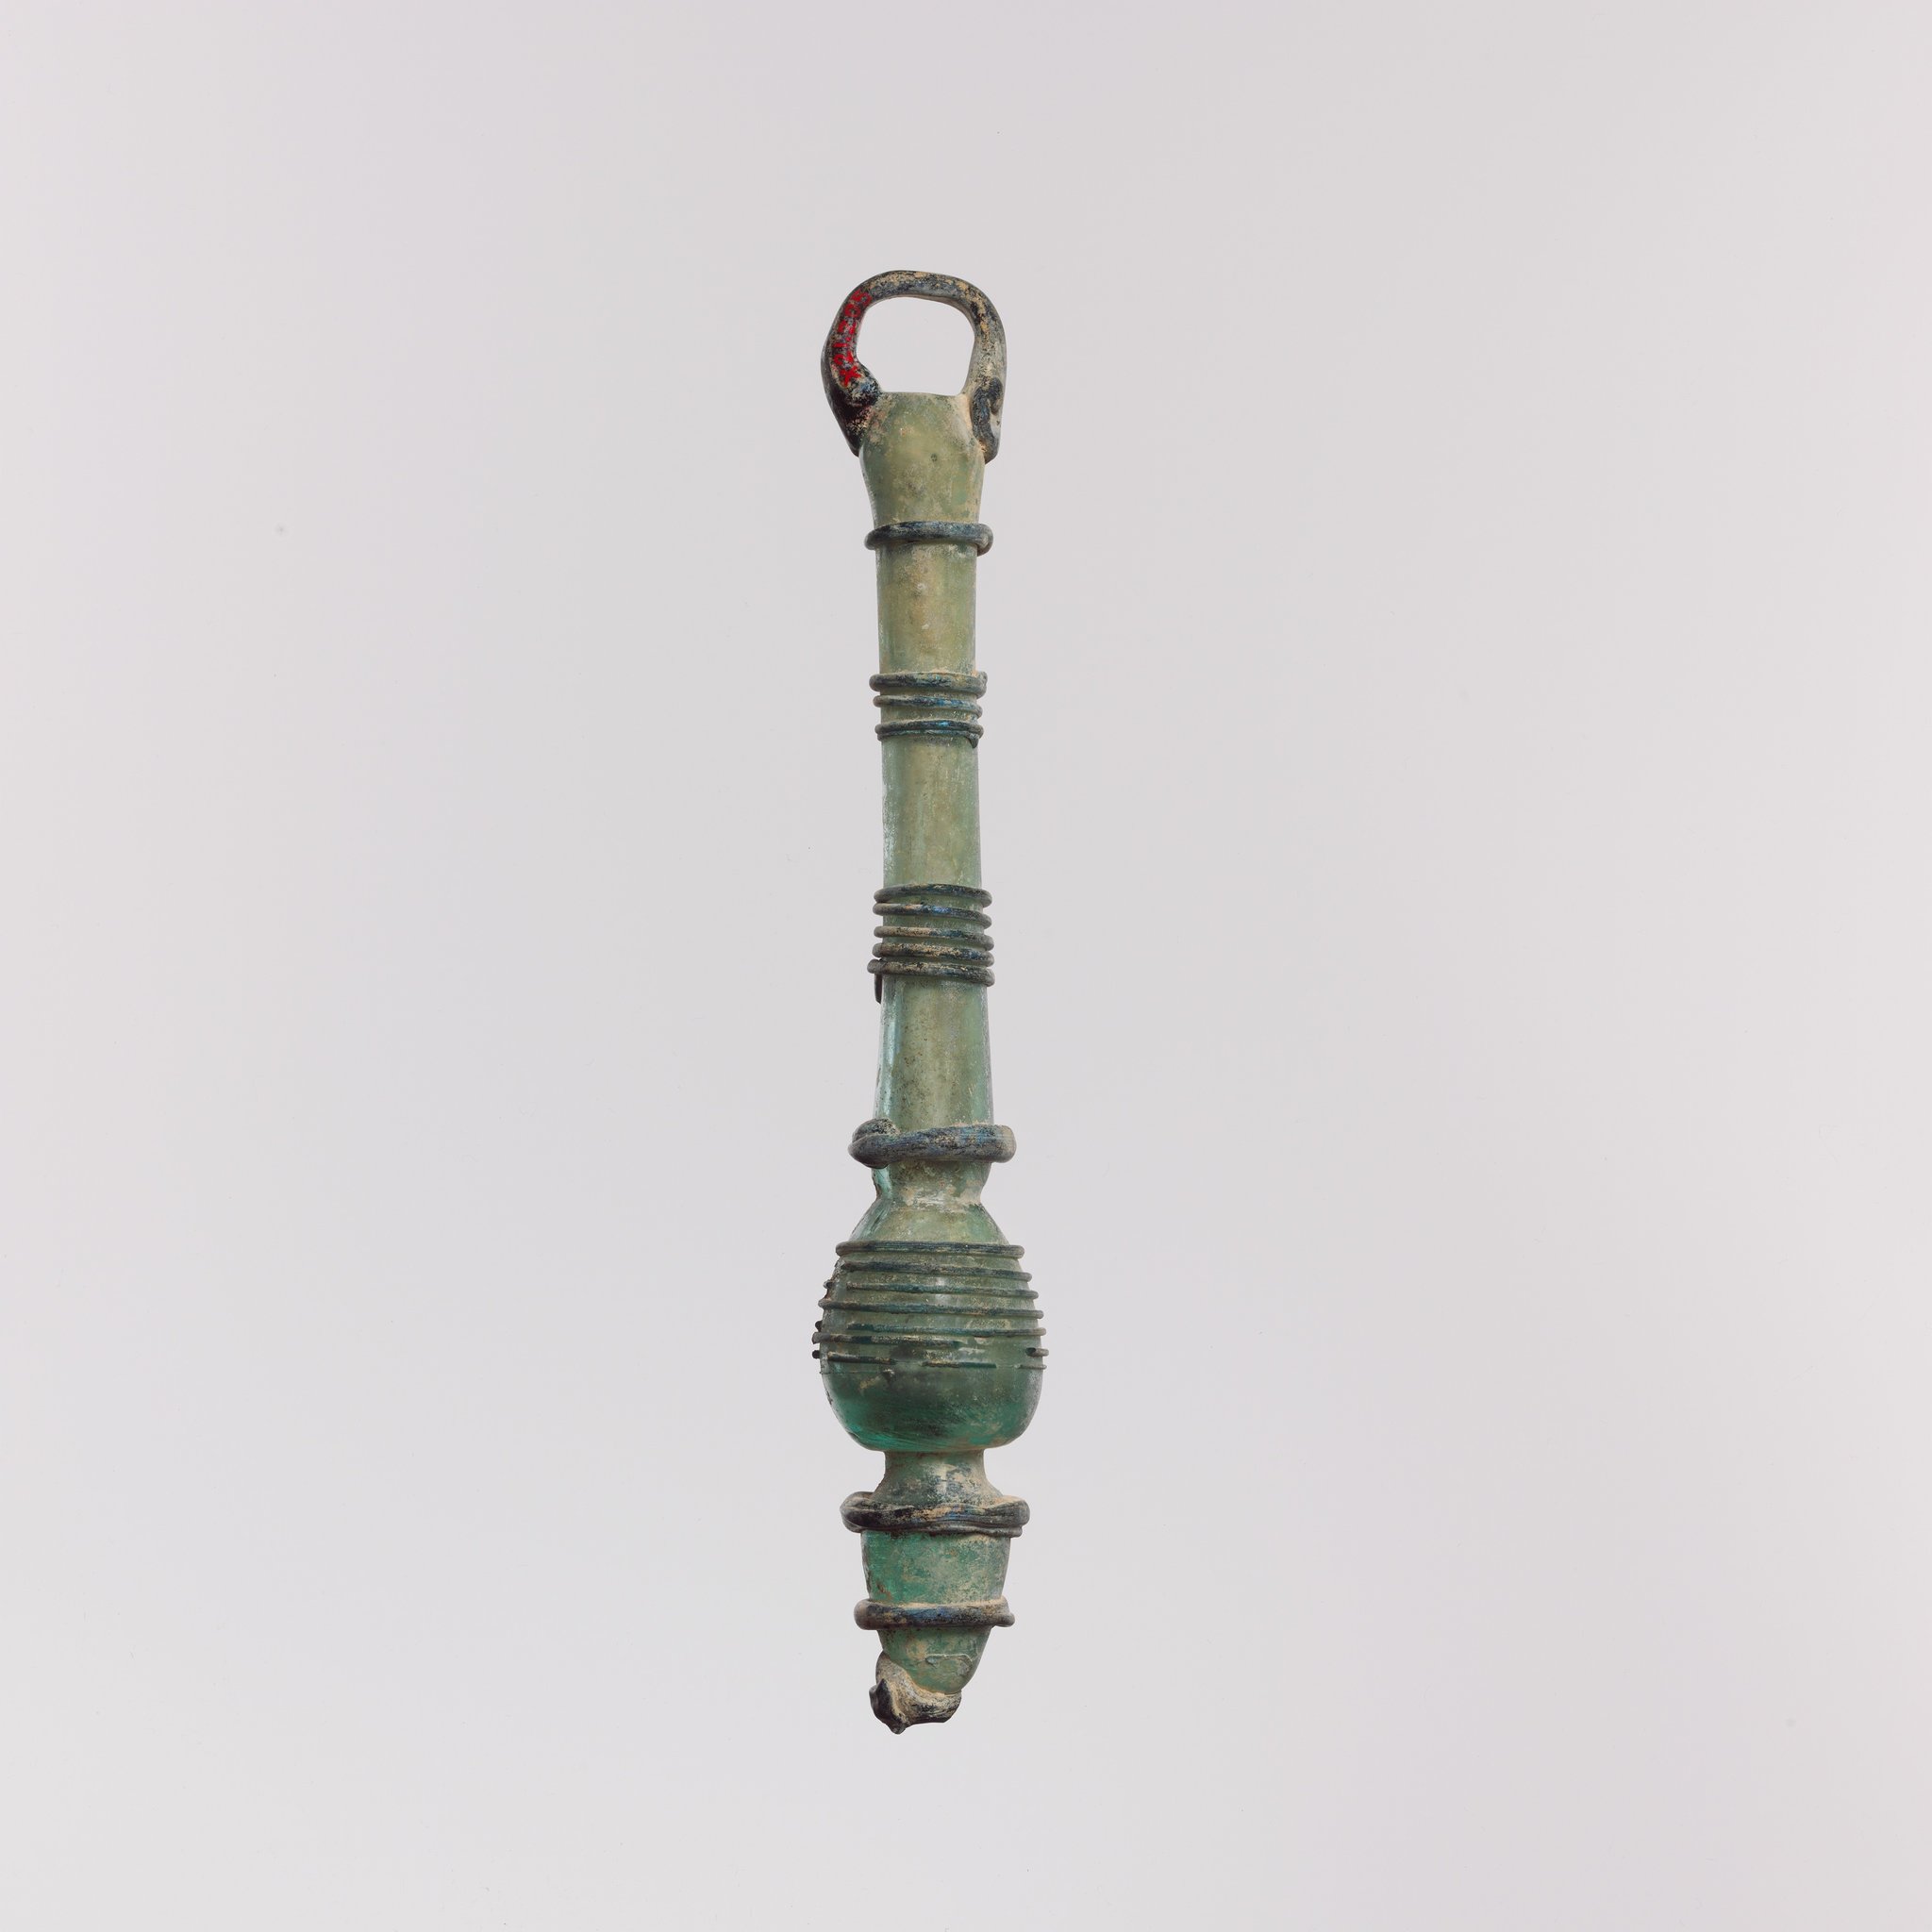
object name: bottle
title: Glass bottle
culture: roman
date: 301-500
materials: glass